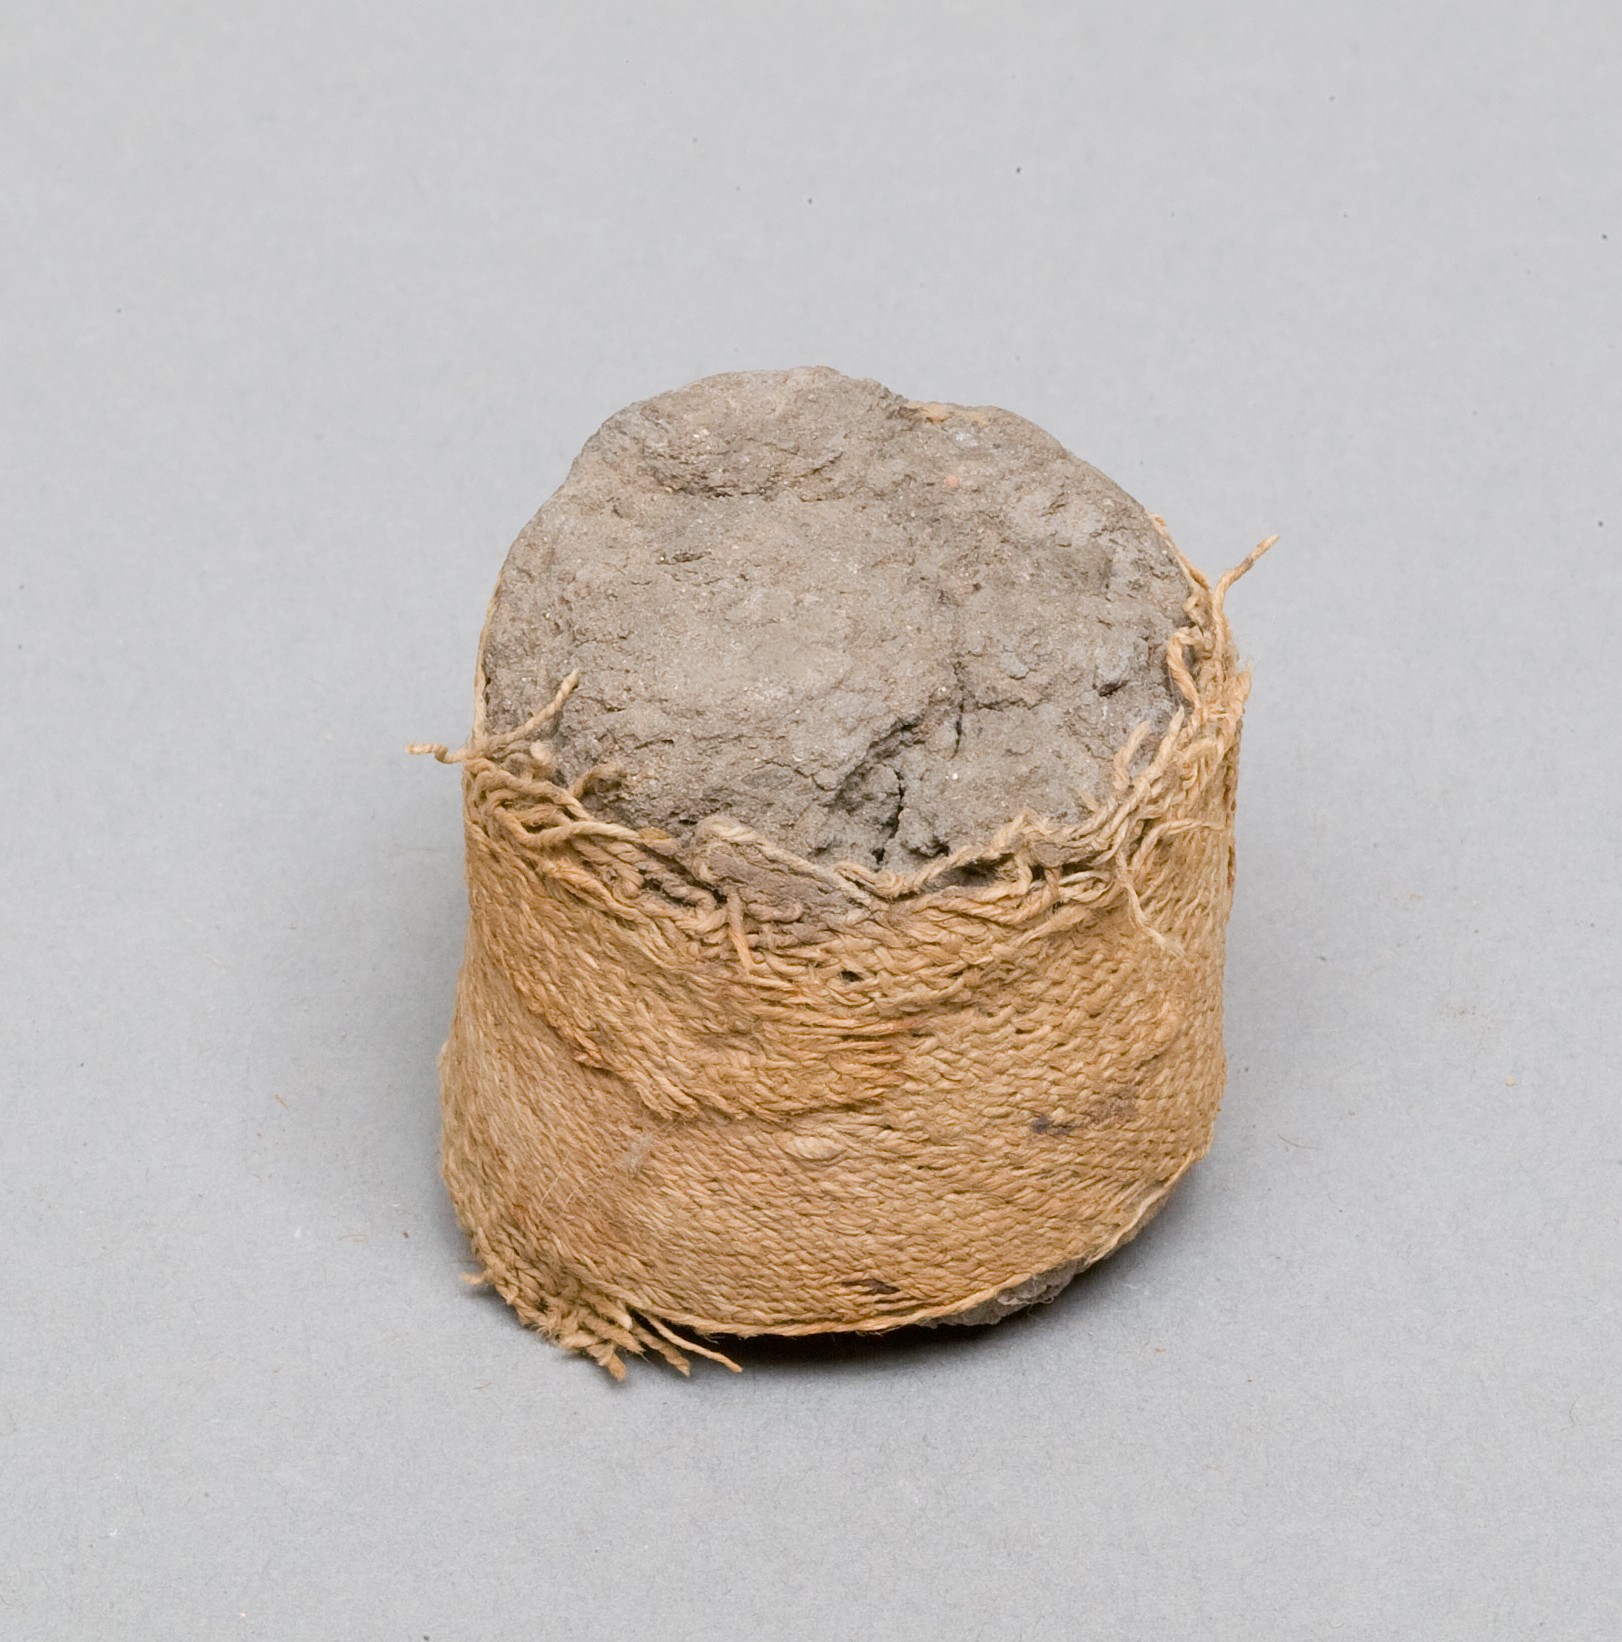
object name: reel, thread wrapped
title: Reel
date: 1295-1070 BCE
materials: linen, mud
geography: egypt